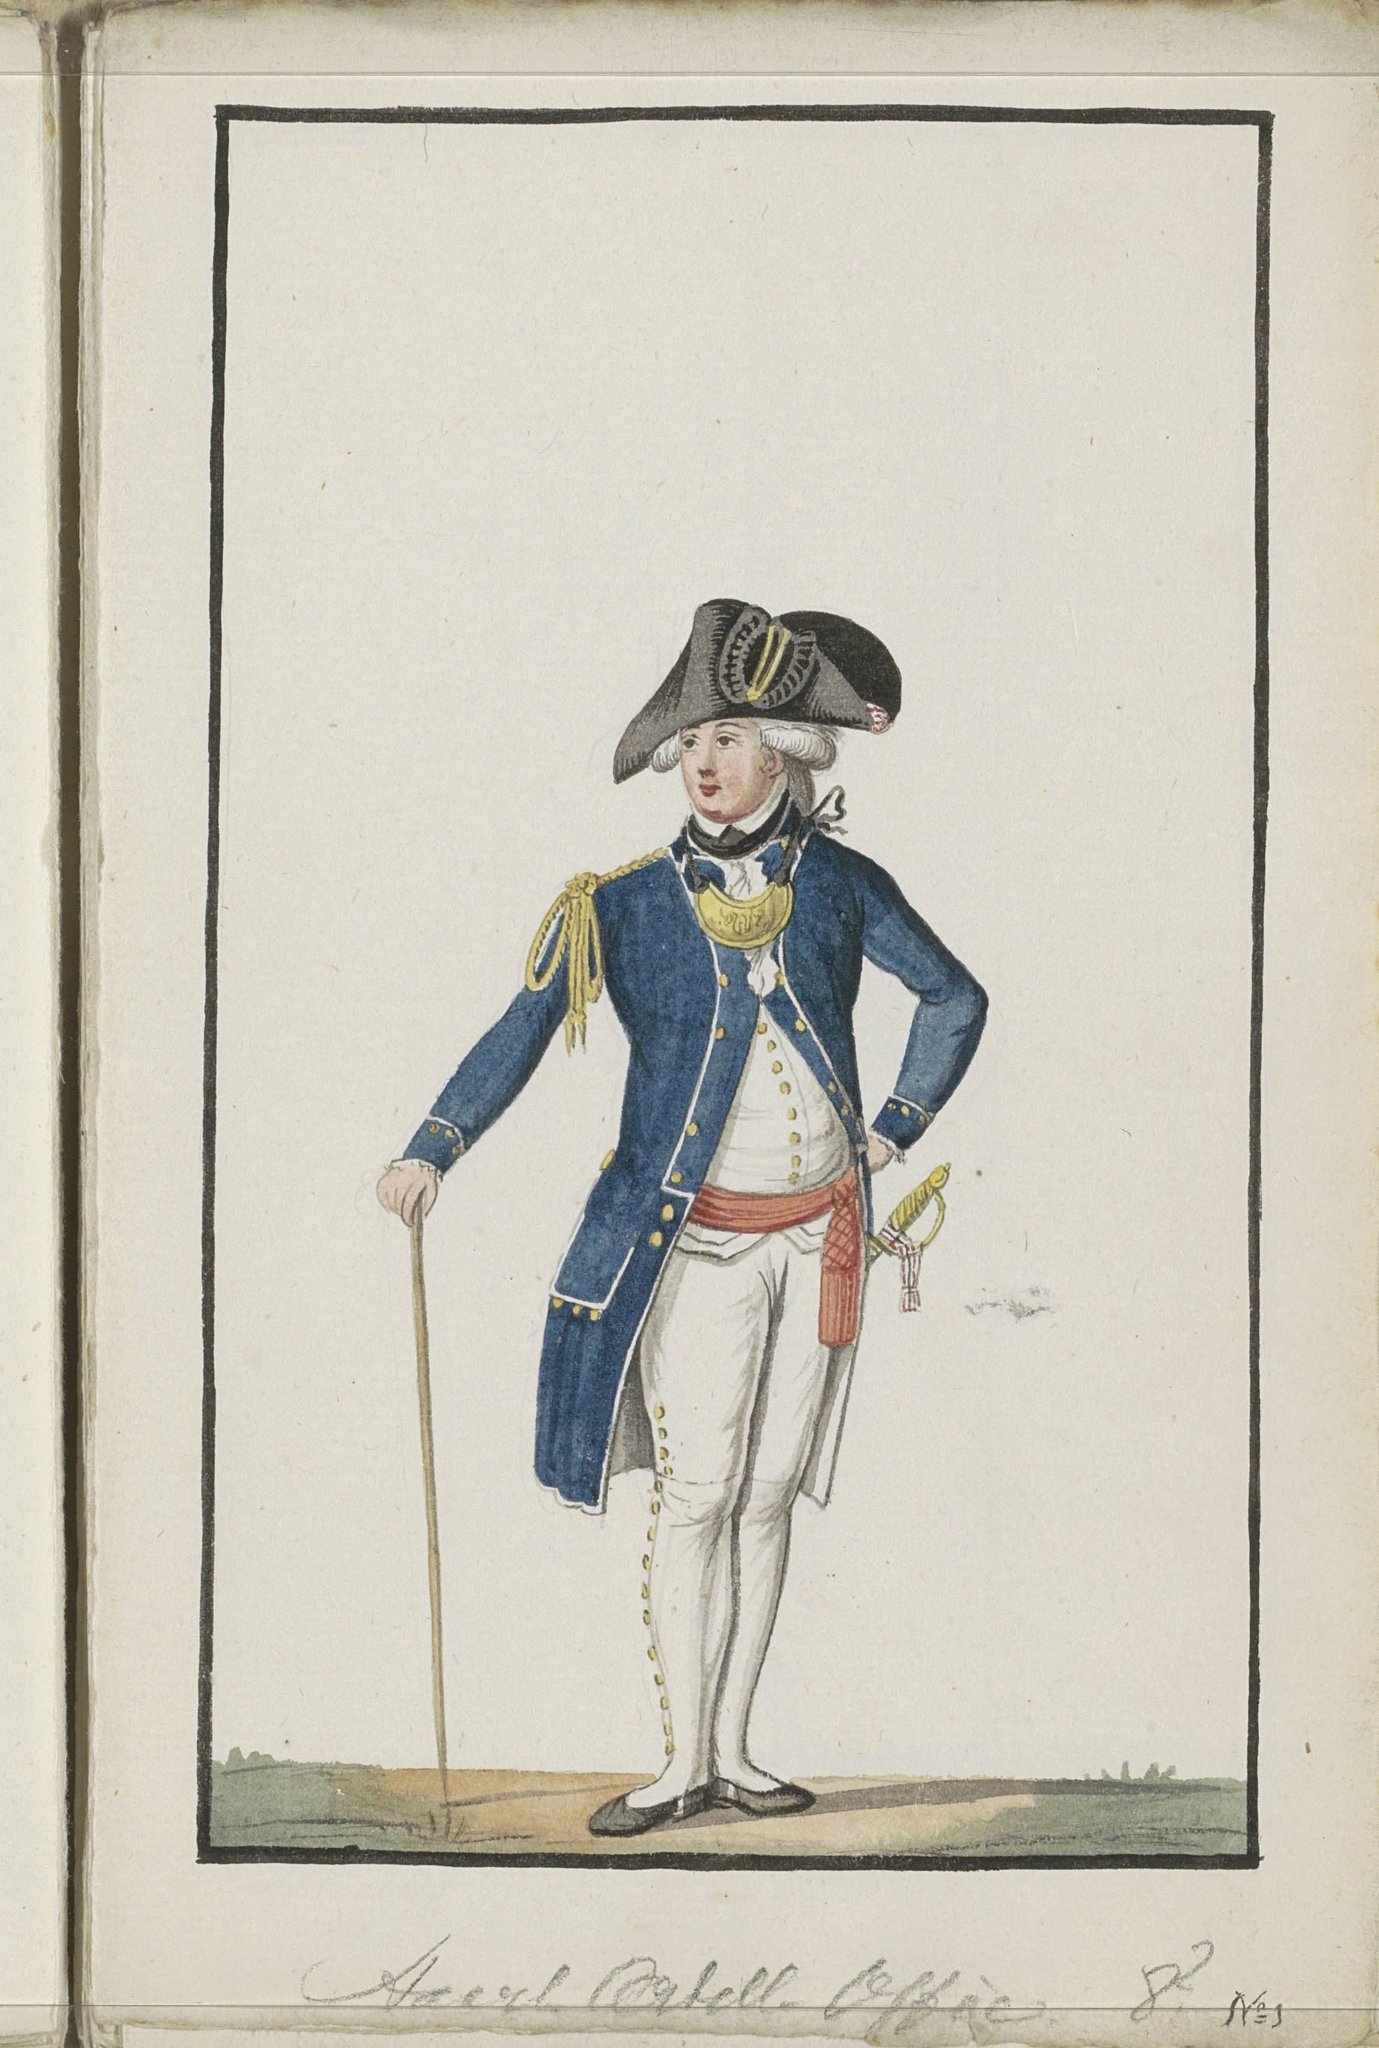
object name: drawing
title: Montering van de Haarlemse artillerie, ca. 1785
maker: Anonymous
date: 1789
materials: paper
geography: northern netherlands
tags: (military) uniforms (+ citizen soldiery, civil guard, citizen militia), haarlem, patriots (1780-1795)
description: Montering of uniform van een officier van de Haarlemse artillerie, ca. 1785. Onderdeel van een schetsboek met 41 gekleurde tekeningen van de monteringen van de gewapende schutterijen en burgercorpsen in Nederland in de periode ca. 1783-1789.